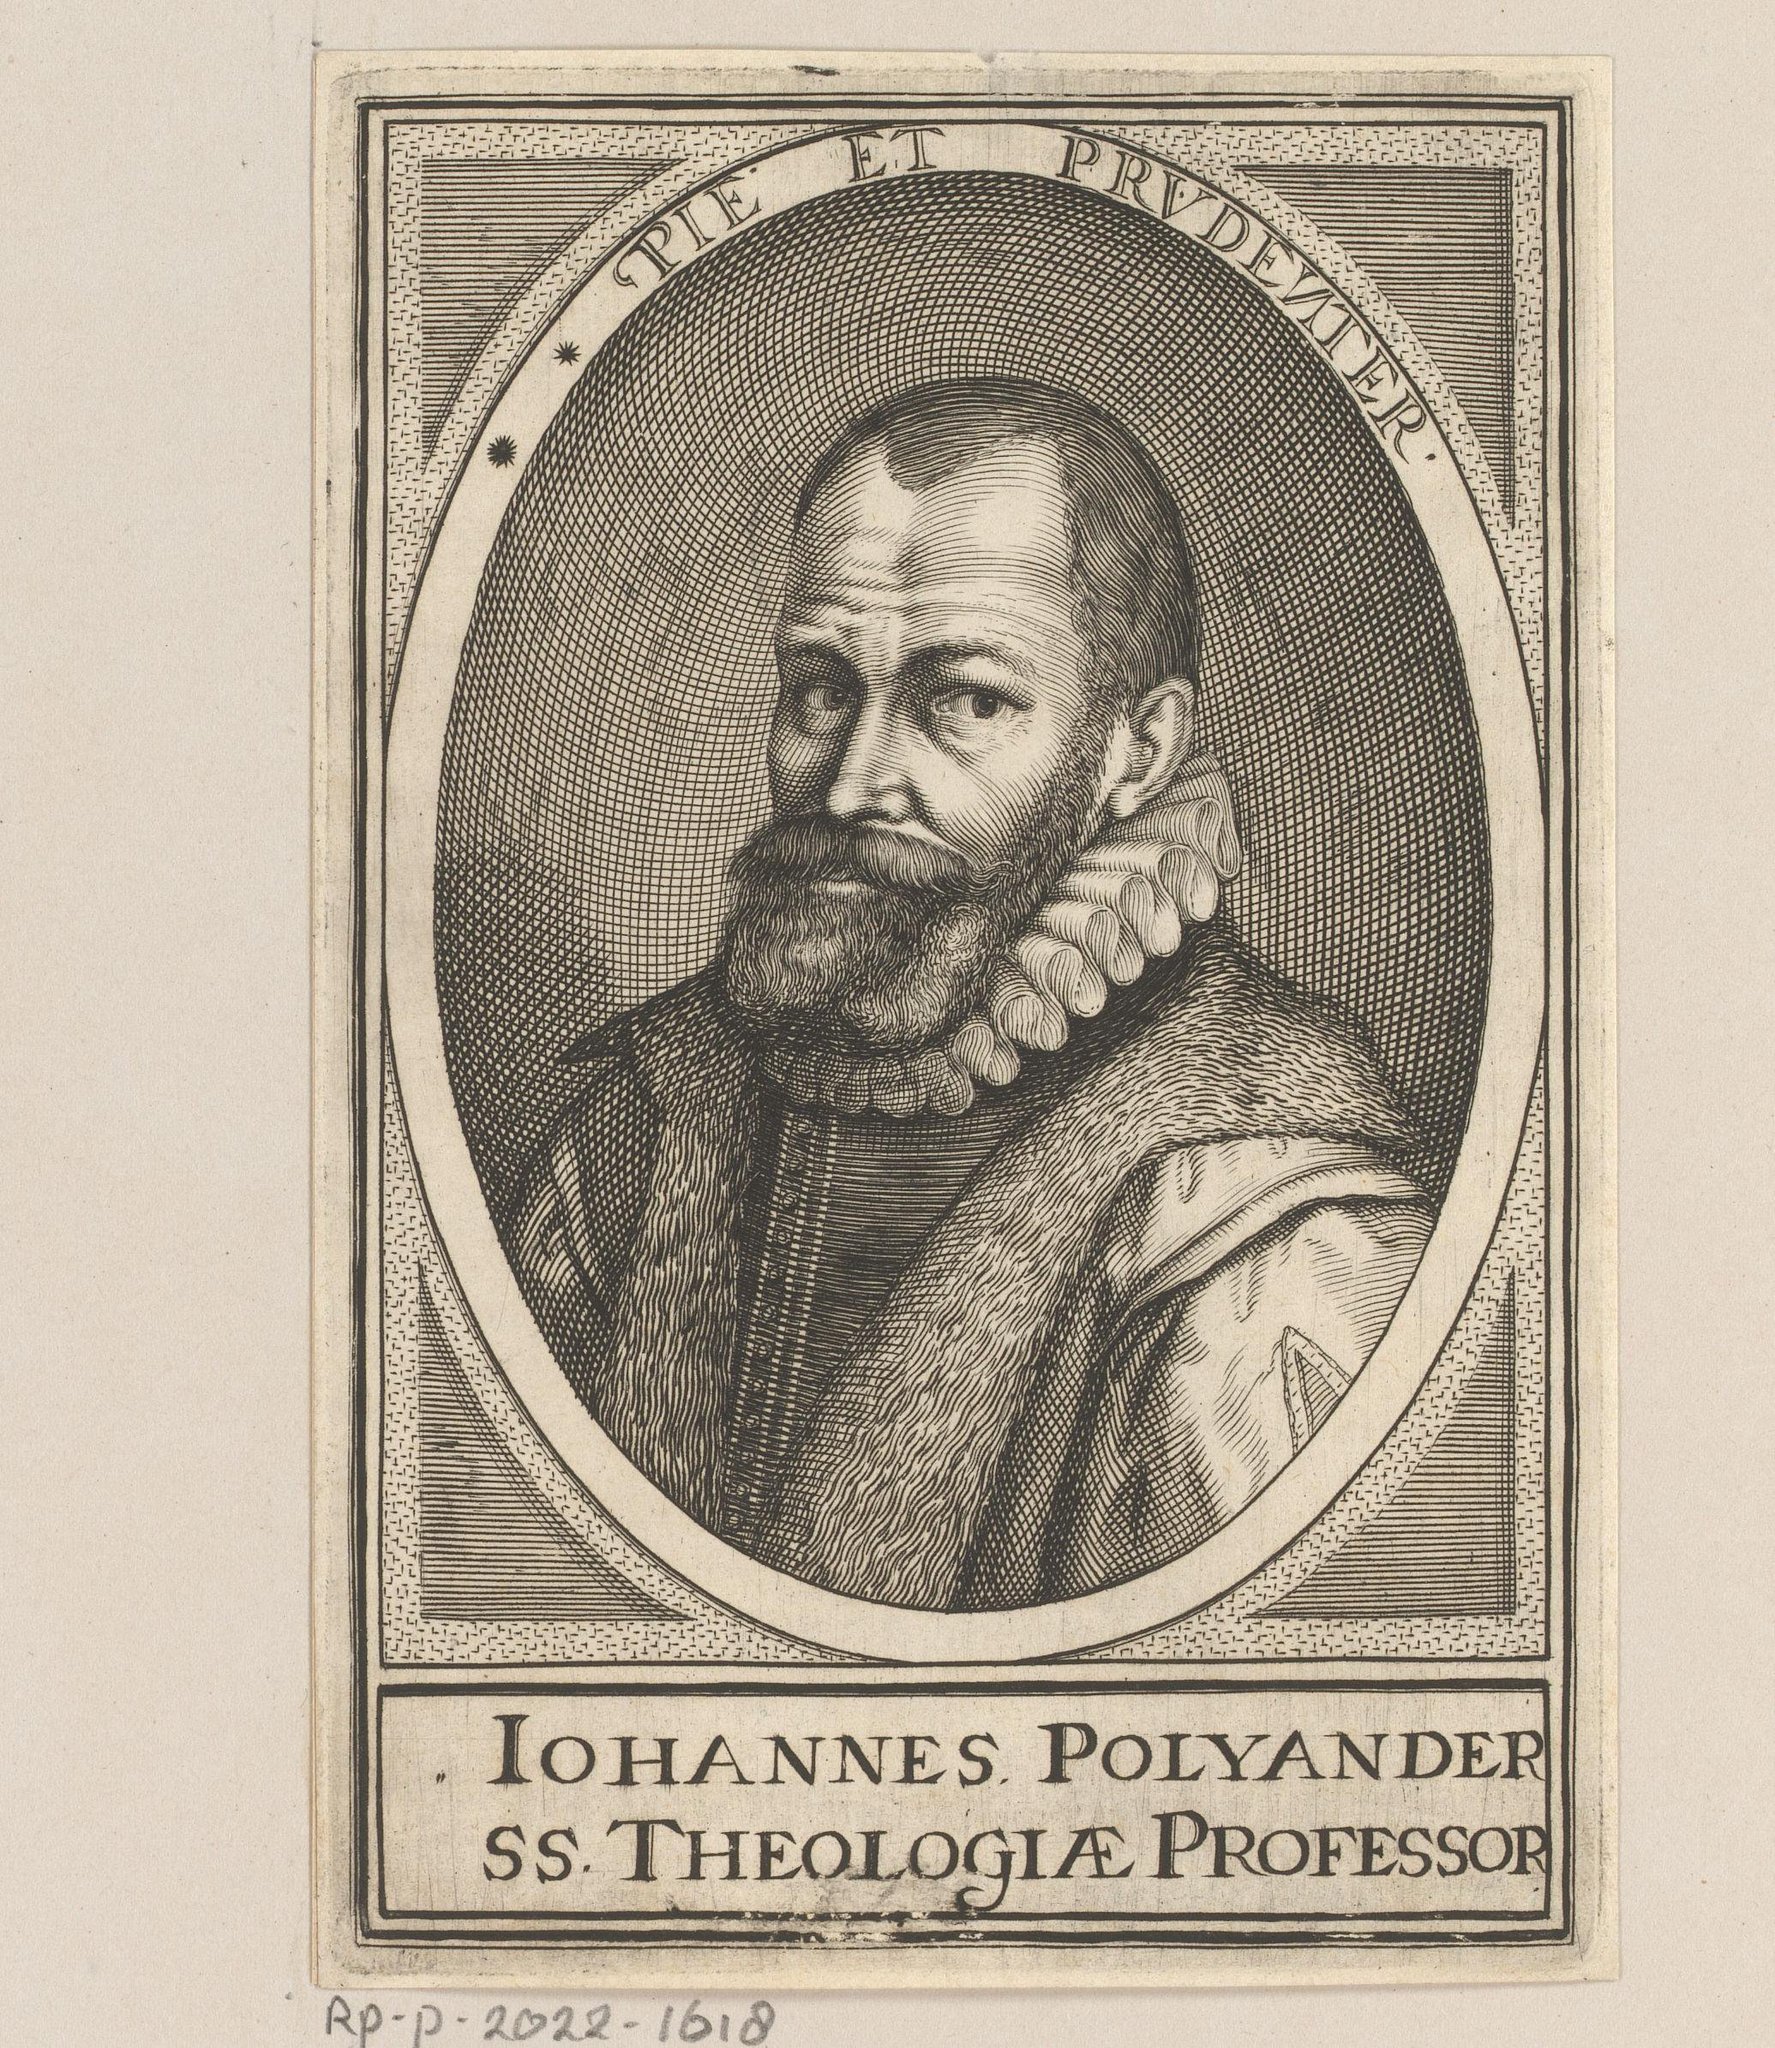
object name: print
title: Portret van Johannes Polyander van Kerckhoven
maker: Anonymous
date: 1611-1699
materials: paper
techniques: engraving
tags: leiden, theologian, historical persons